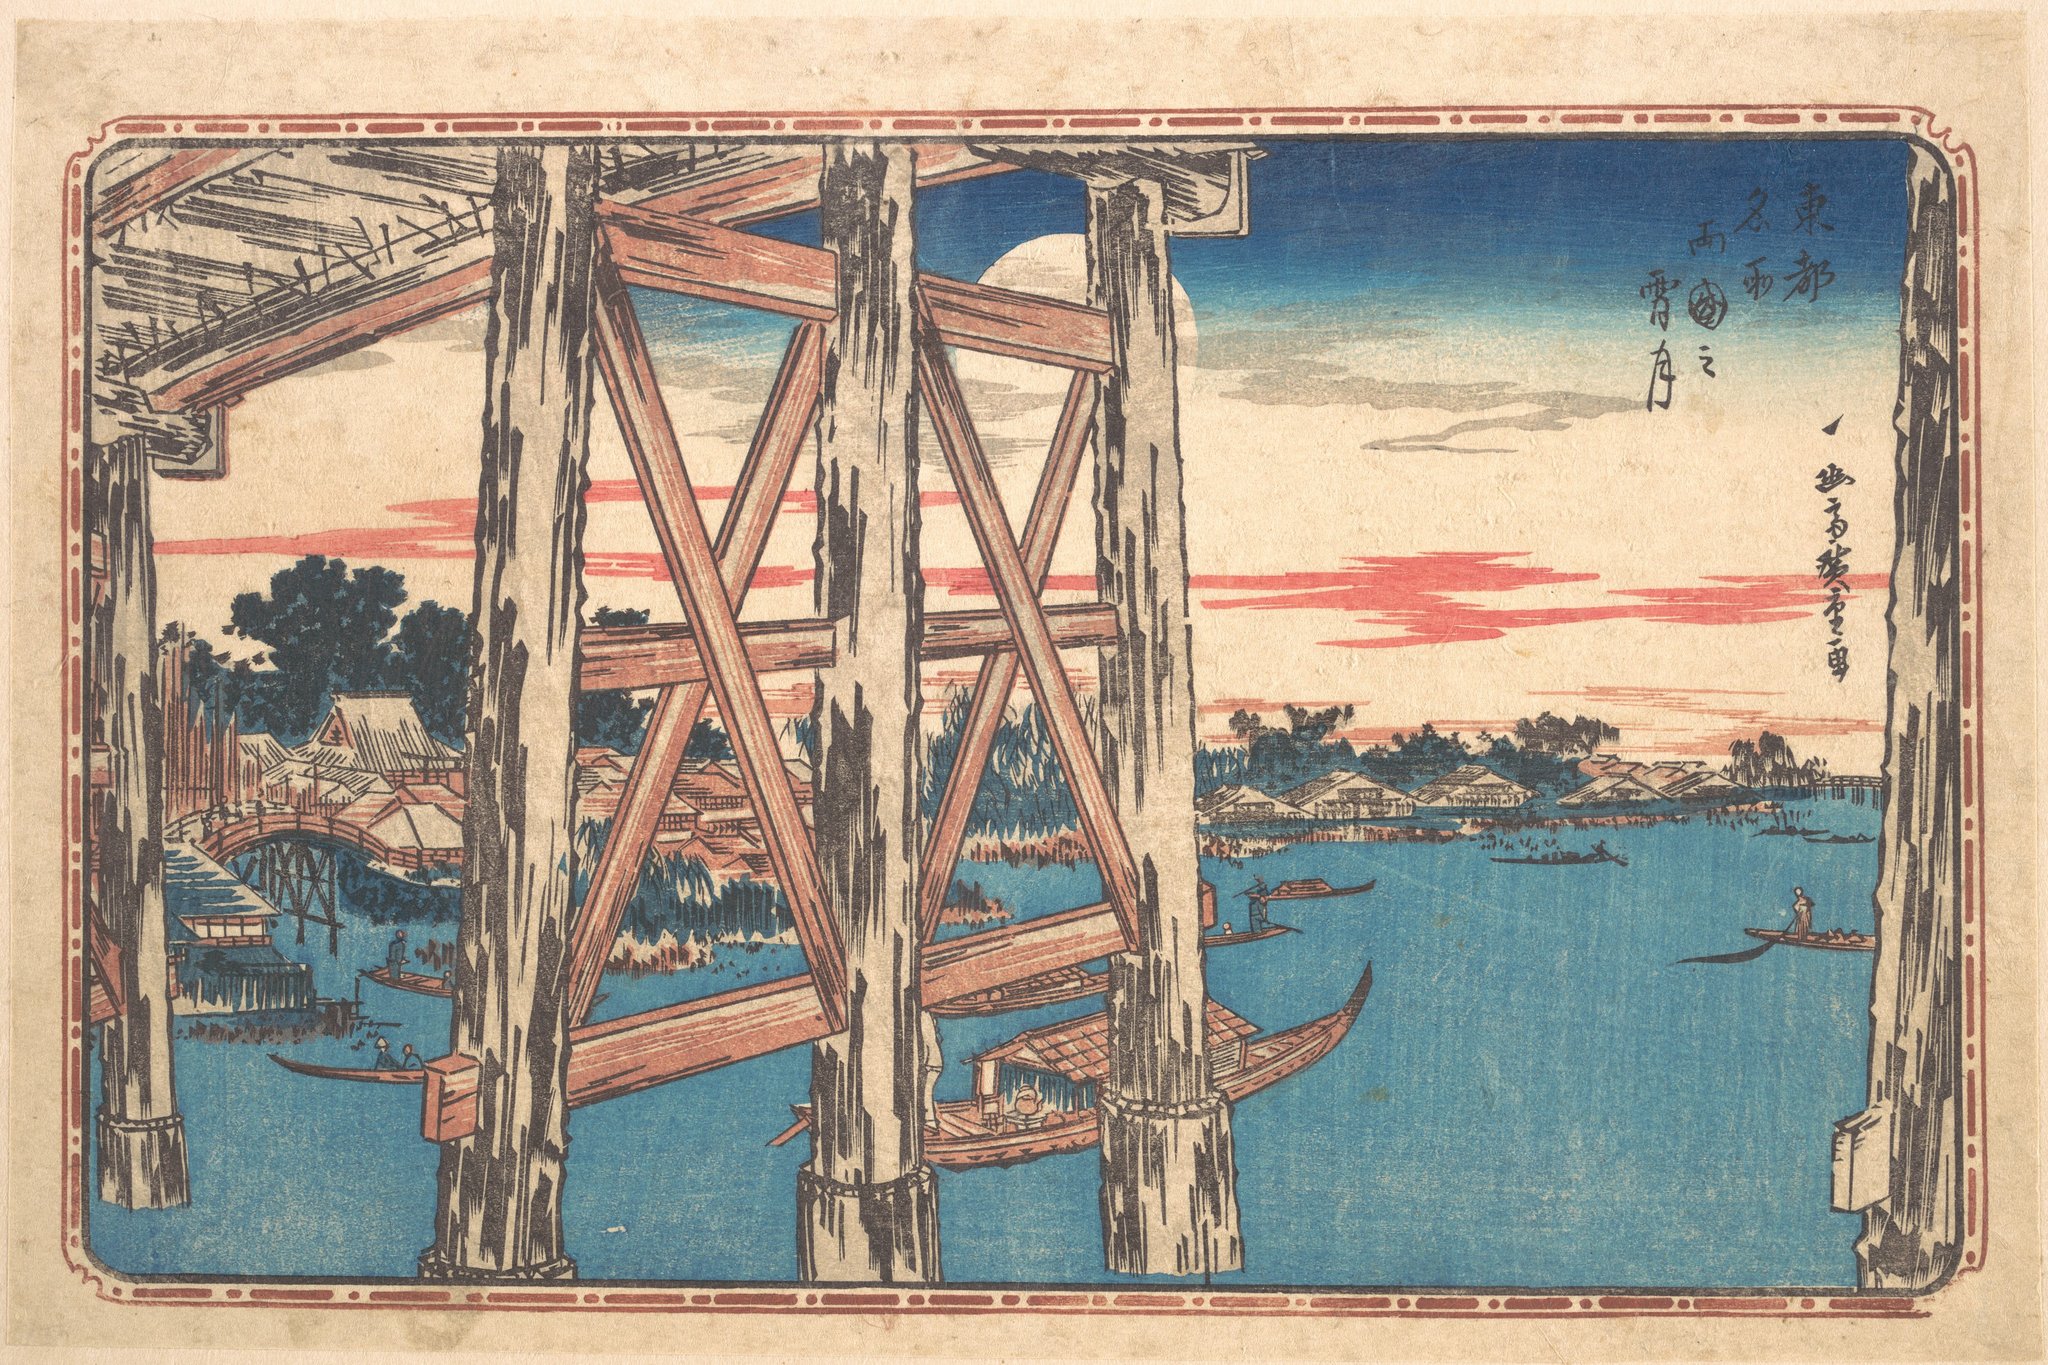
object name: print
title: Twilight Moon at Ryōgoku Bridge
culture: japanese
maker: utagawa hiroshige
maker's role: artist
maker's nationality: japanese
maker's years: 1797-1858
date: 1797-1858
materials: ink, paper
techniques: woodblock print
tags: houses,bridges,moon,trees,boats